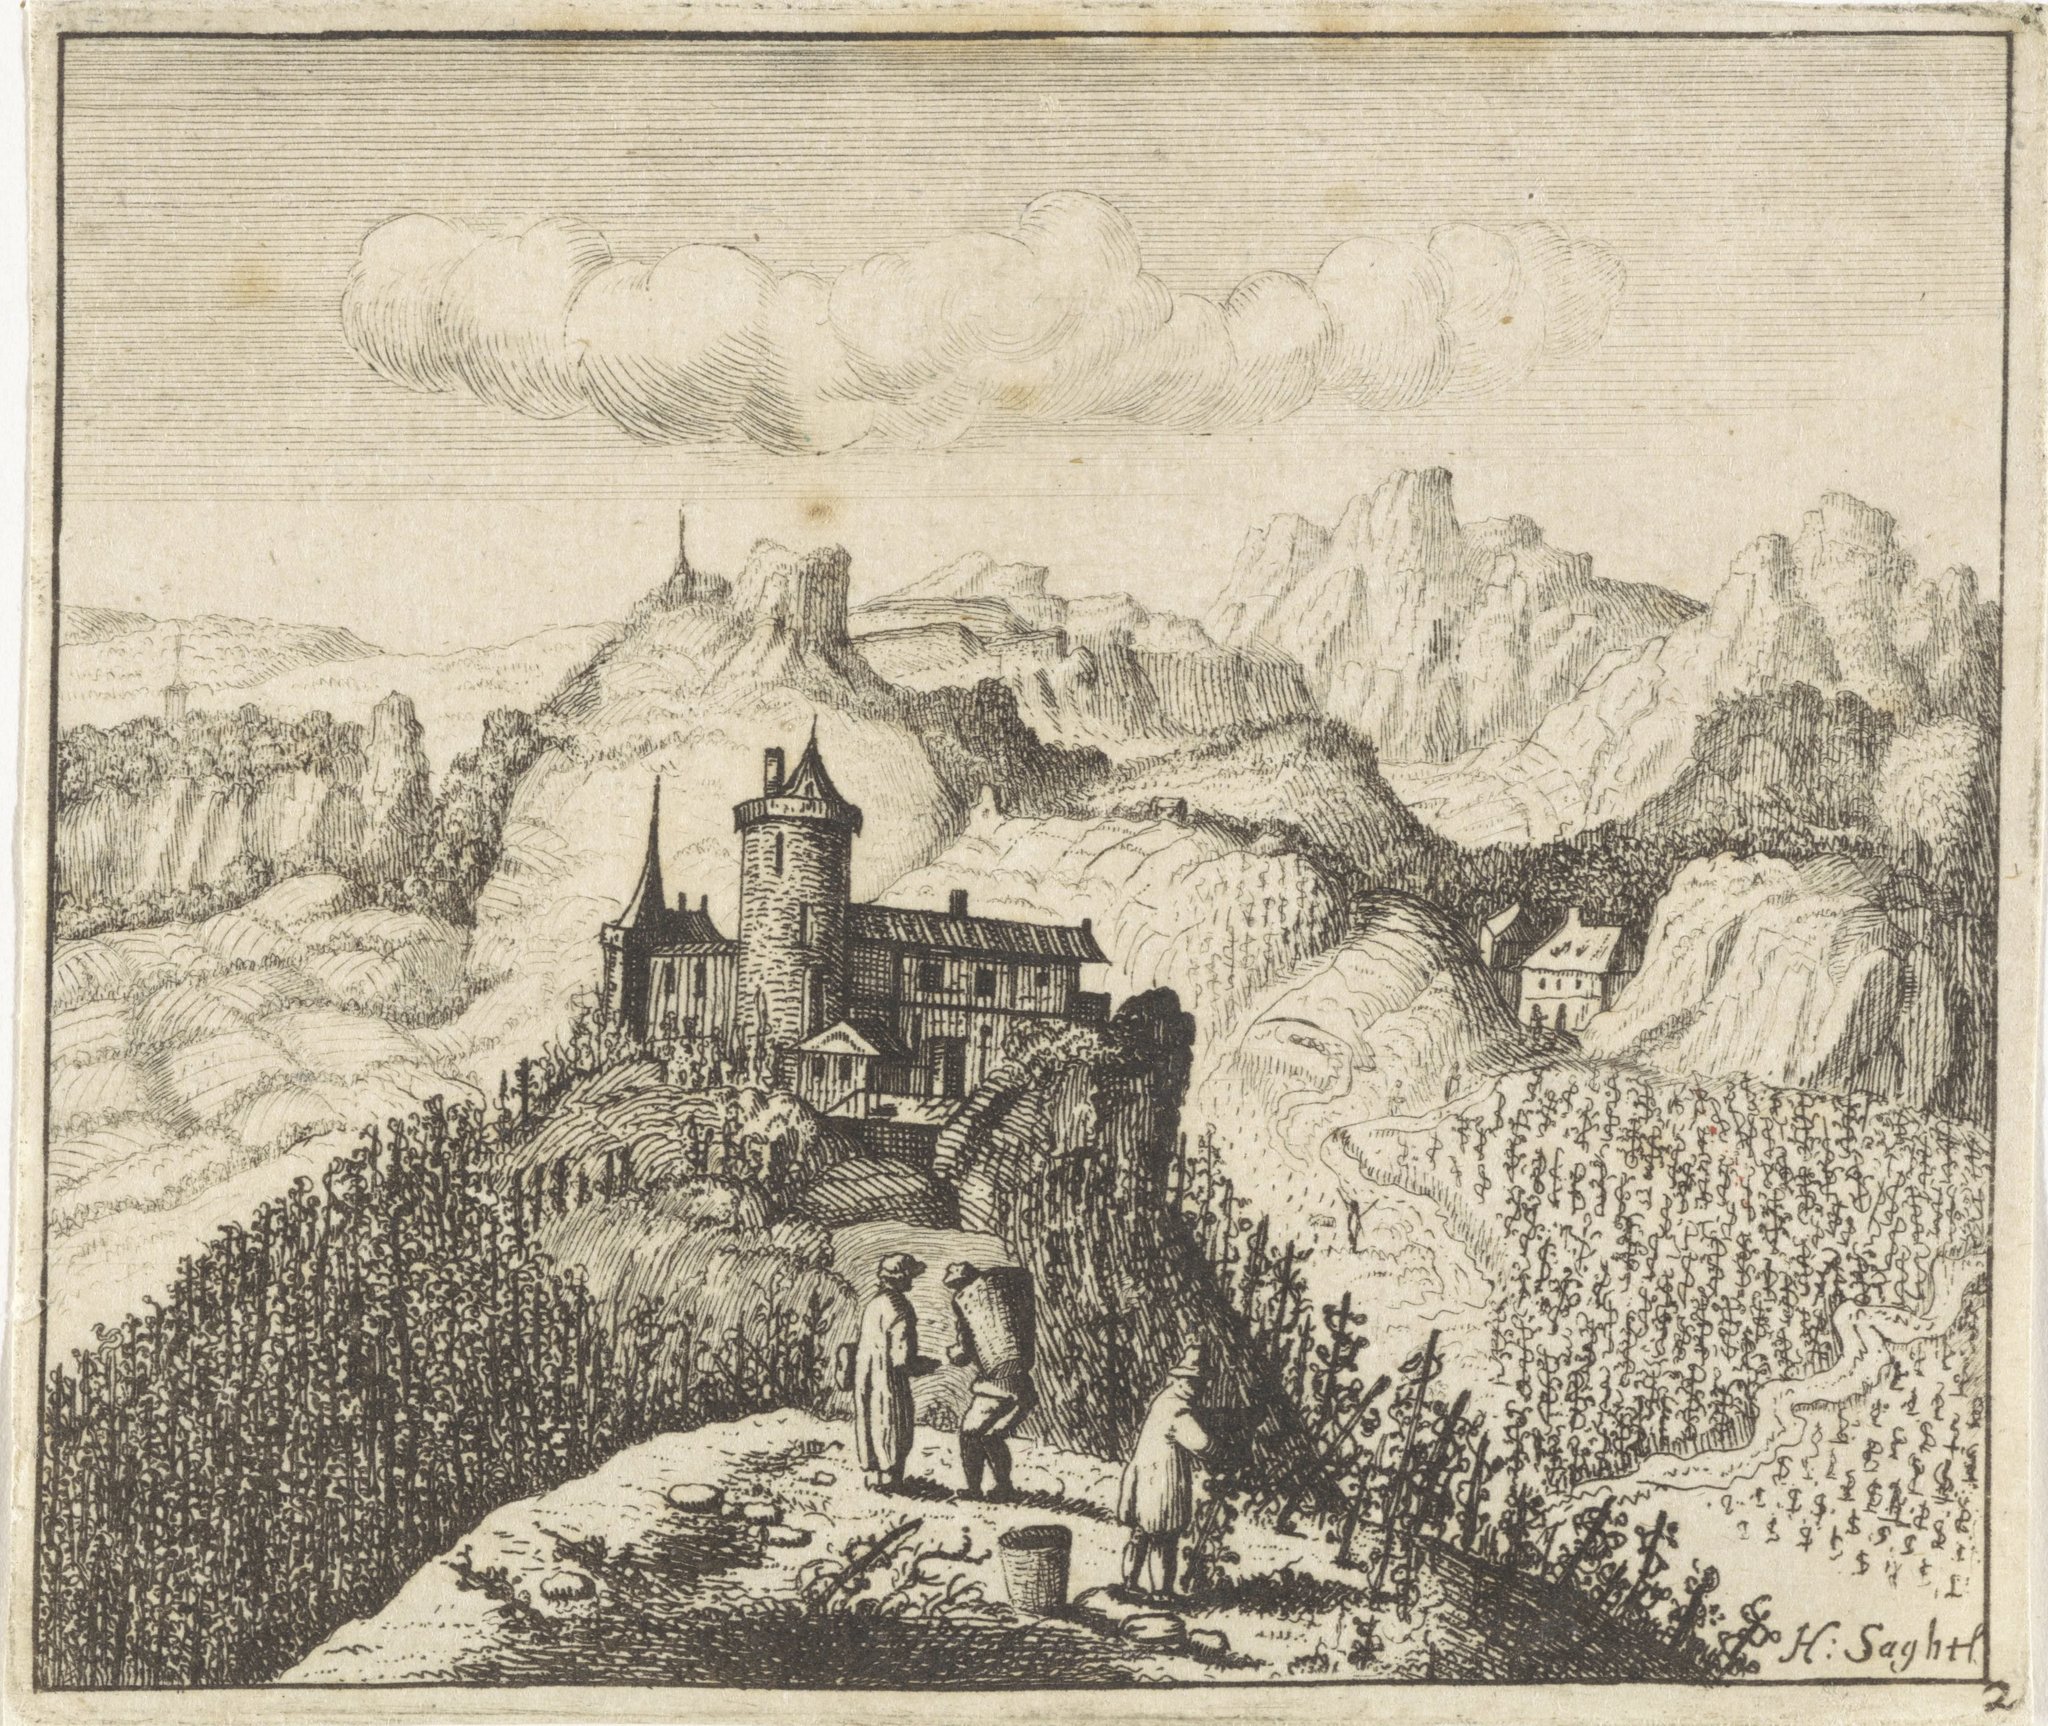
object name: print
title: Bergachtig landschap met druivenplukkers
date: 1668-1707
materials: paper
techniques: etching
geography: northern netherlands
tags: vineyard, landscape with tower or castle, vintage, grape harvest, mountains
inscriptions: collector's mark: Lugt 240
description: Vooraan zijn enkele druivenplukkers aan het werk. Achter hen ligt een wijngaard op een berg. Op de top van de berg staat een versterkt gebouw. In het dal ligt rechts nog een wijngaard.